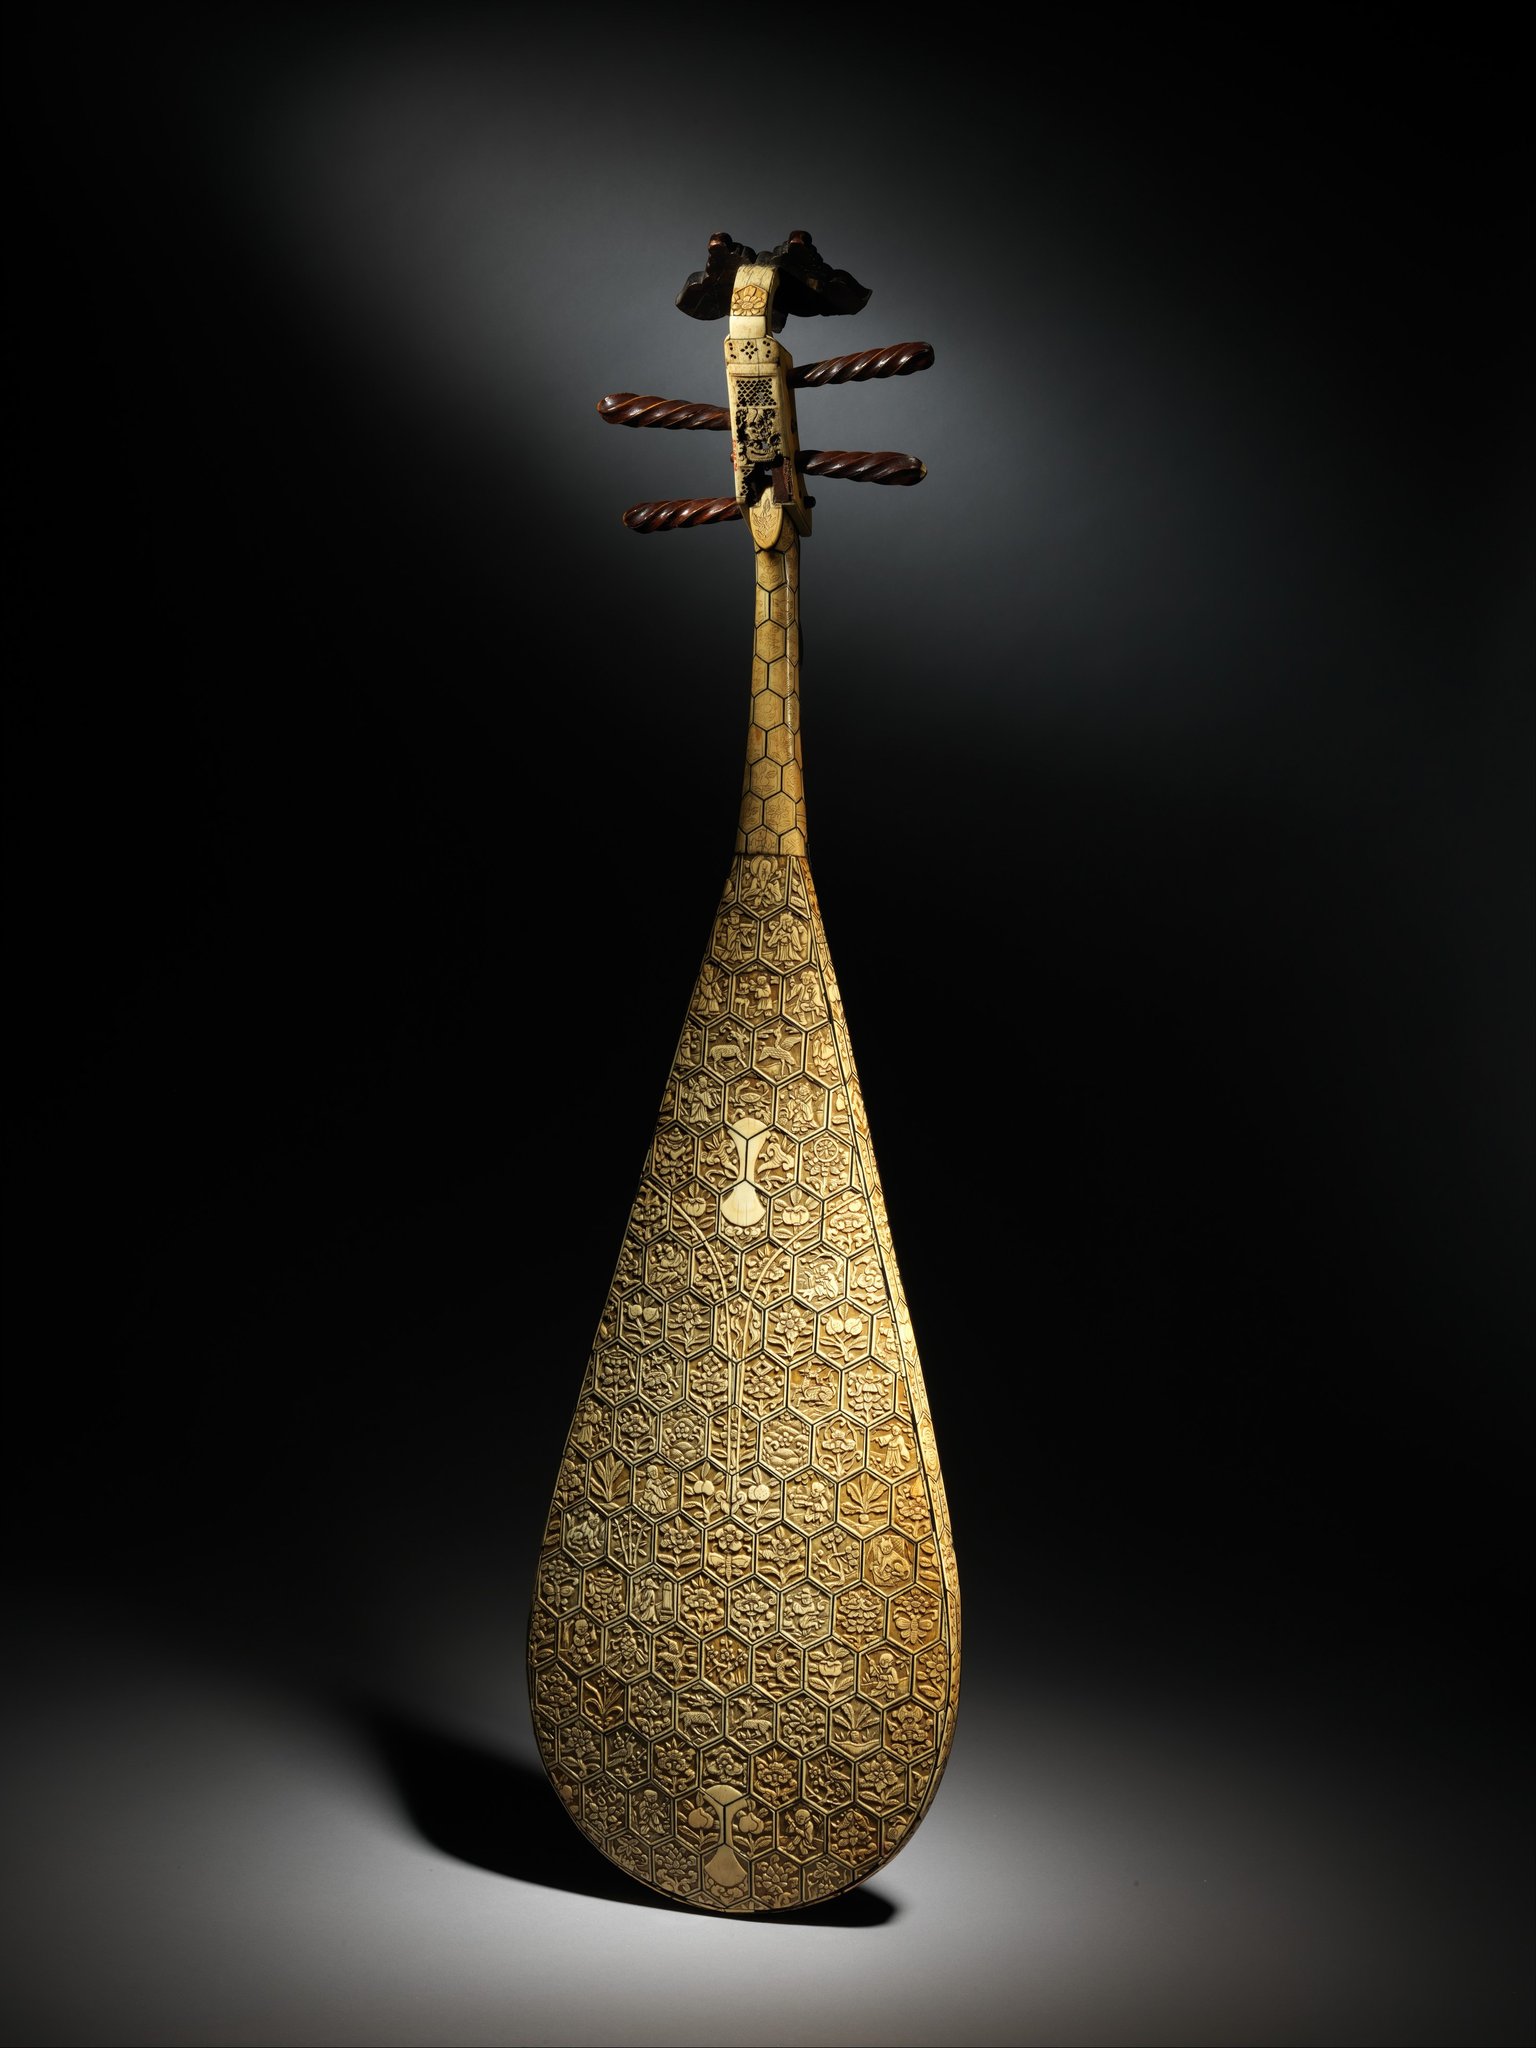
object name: pipa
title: Pipa (琵琶 )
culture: chinese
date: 1567-1633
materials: bone, ivory, silk, wood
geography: china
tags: animals,birds,men,flowers